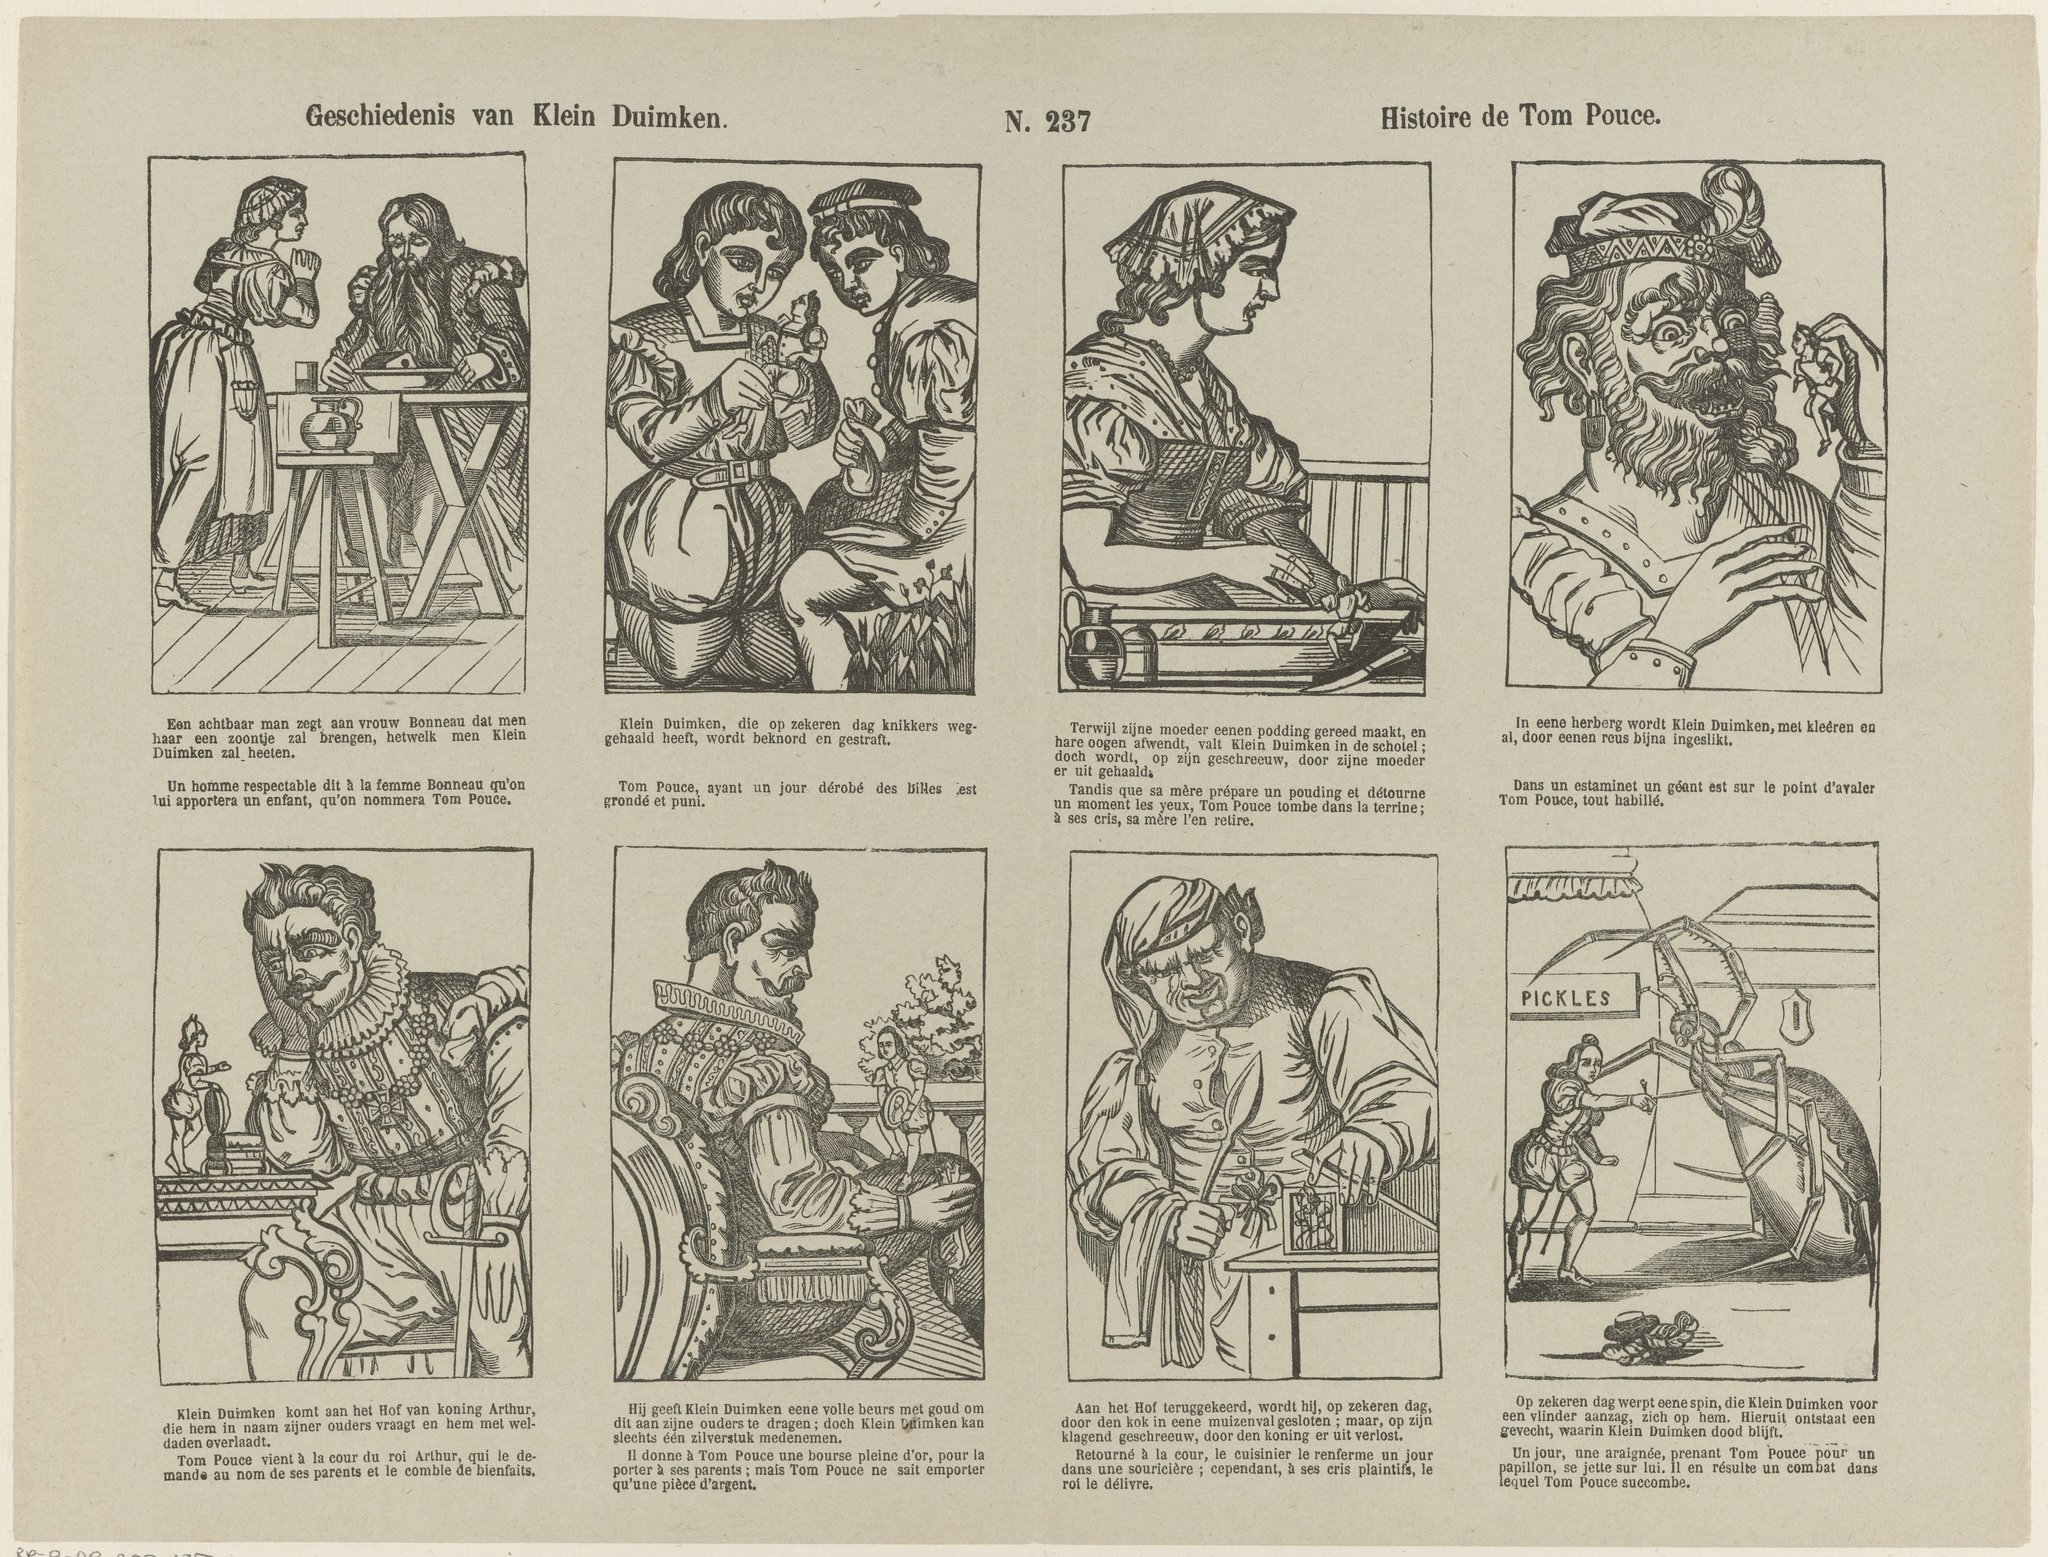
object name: print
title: Geschiedenis van Klein Duimken / Histoire de Tom Pouce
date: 1800-1833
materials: paper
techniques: letterpress printing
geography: turnhout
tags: tales and fairy tales: little thumbling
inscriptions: collector's mark: Lugt 2760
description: Blad met 8 voorstellingen uit het verhaal van Klein Duimpje. Onder elke afbeelding een onderschrift in het Nederlands en in het Frans. Genummerd midden boven: N. 237.